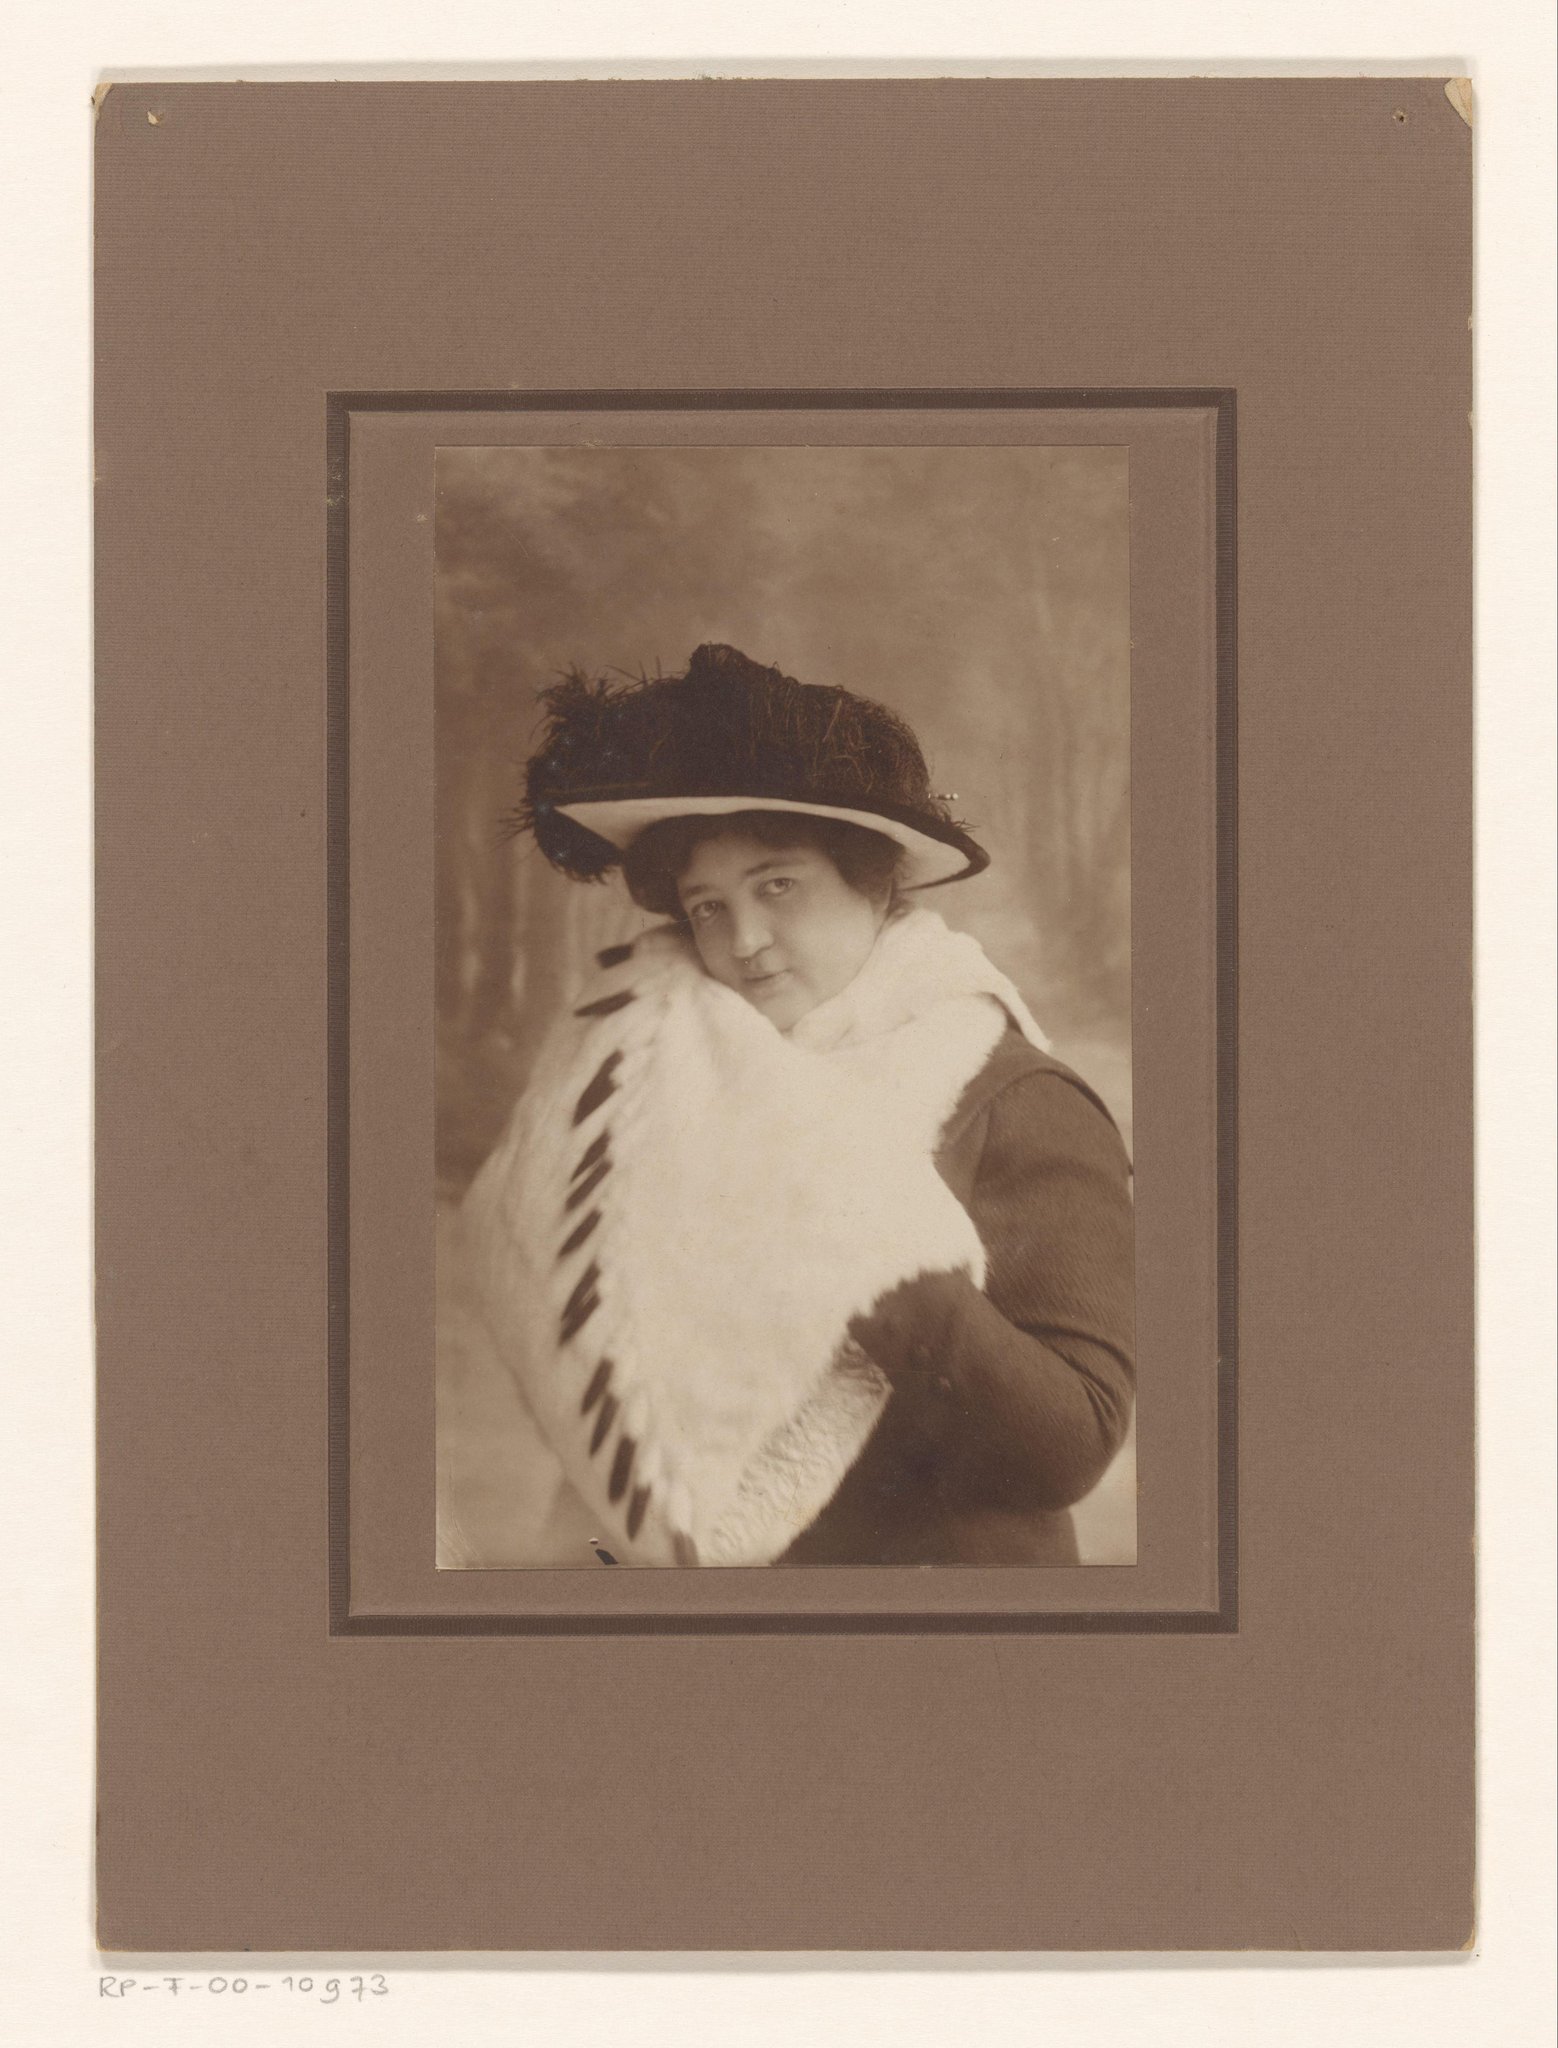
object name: photograph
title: Portret van een onbekende vrouw met een handmof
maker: Anonymous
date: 1880-1920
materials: photographic support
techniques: matte daylight collodion silver print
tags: accessories (~ clothing), historical persons not known by name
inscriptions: annotation: ‘[...]na ls, 17aug.’